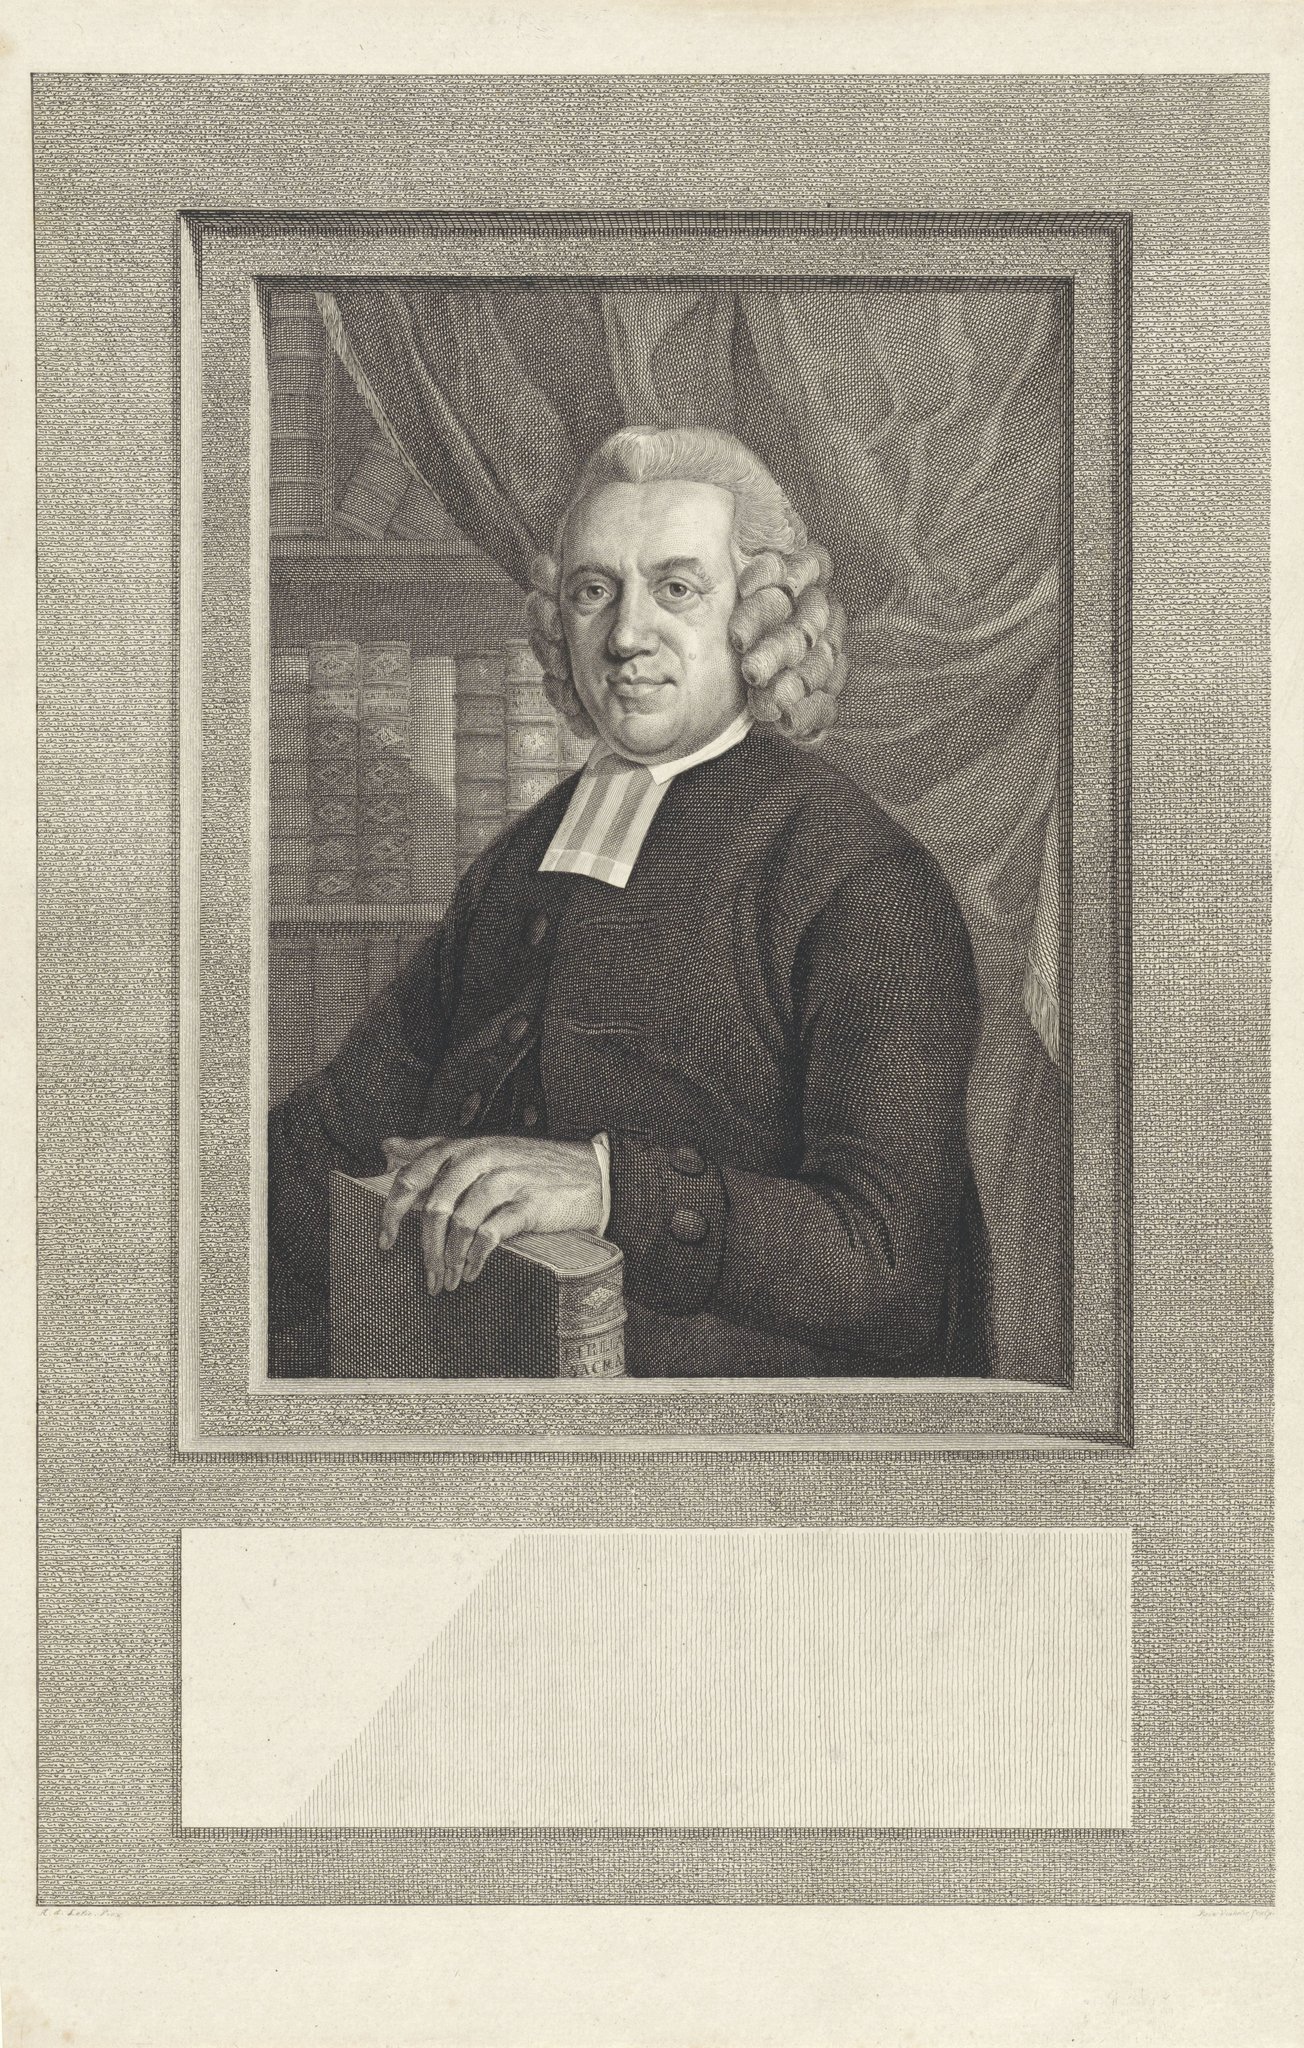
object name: print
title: Portret van Petrus Haack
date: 1791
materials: paper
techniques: engraving, etching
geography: amsterdam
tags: amsterdam, petrus haack, study; 'studiolo'; library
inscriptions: collector's mark: Lugt 240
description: Portret van Petrus Haack, dichter en predikant te Amsterdam.